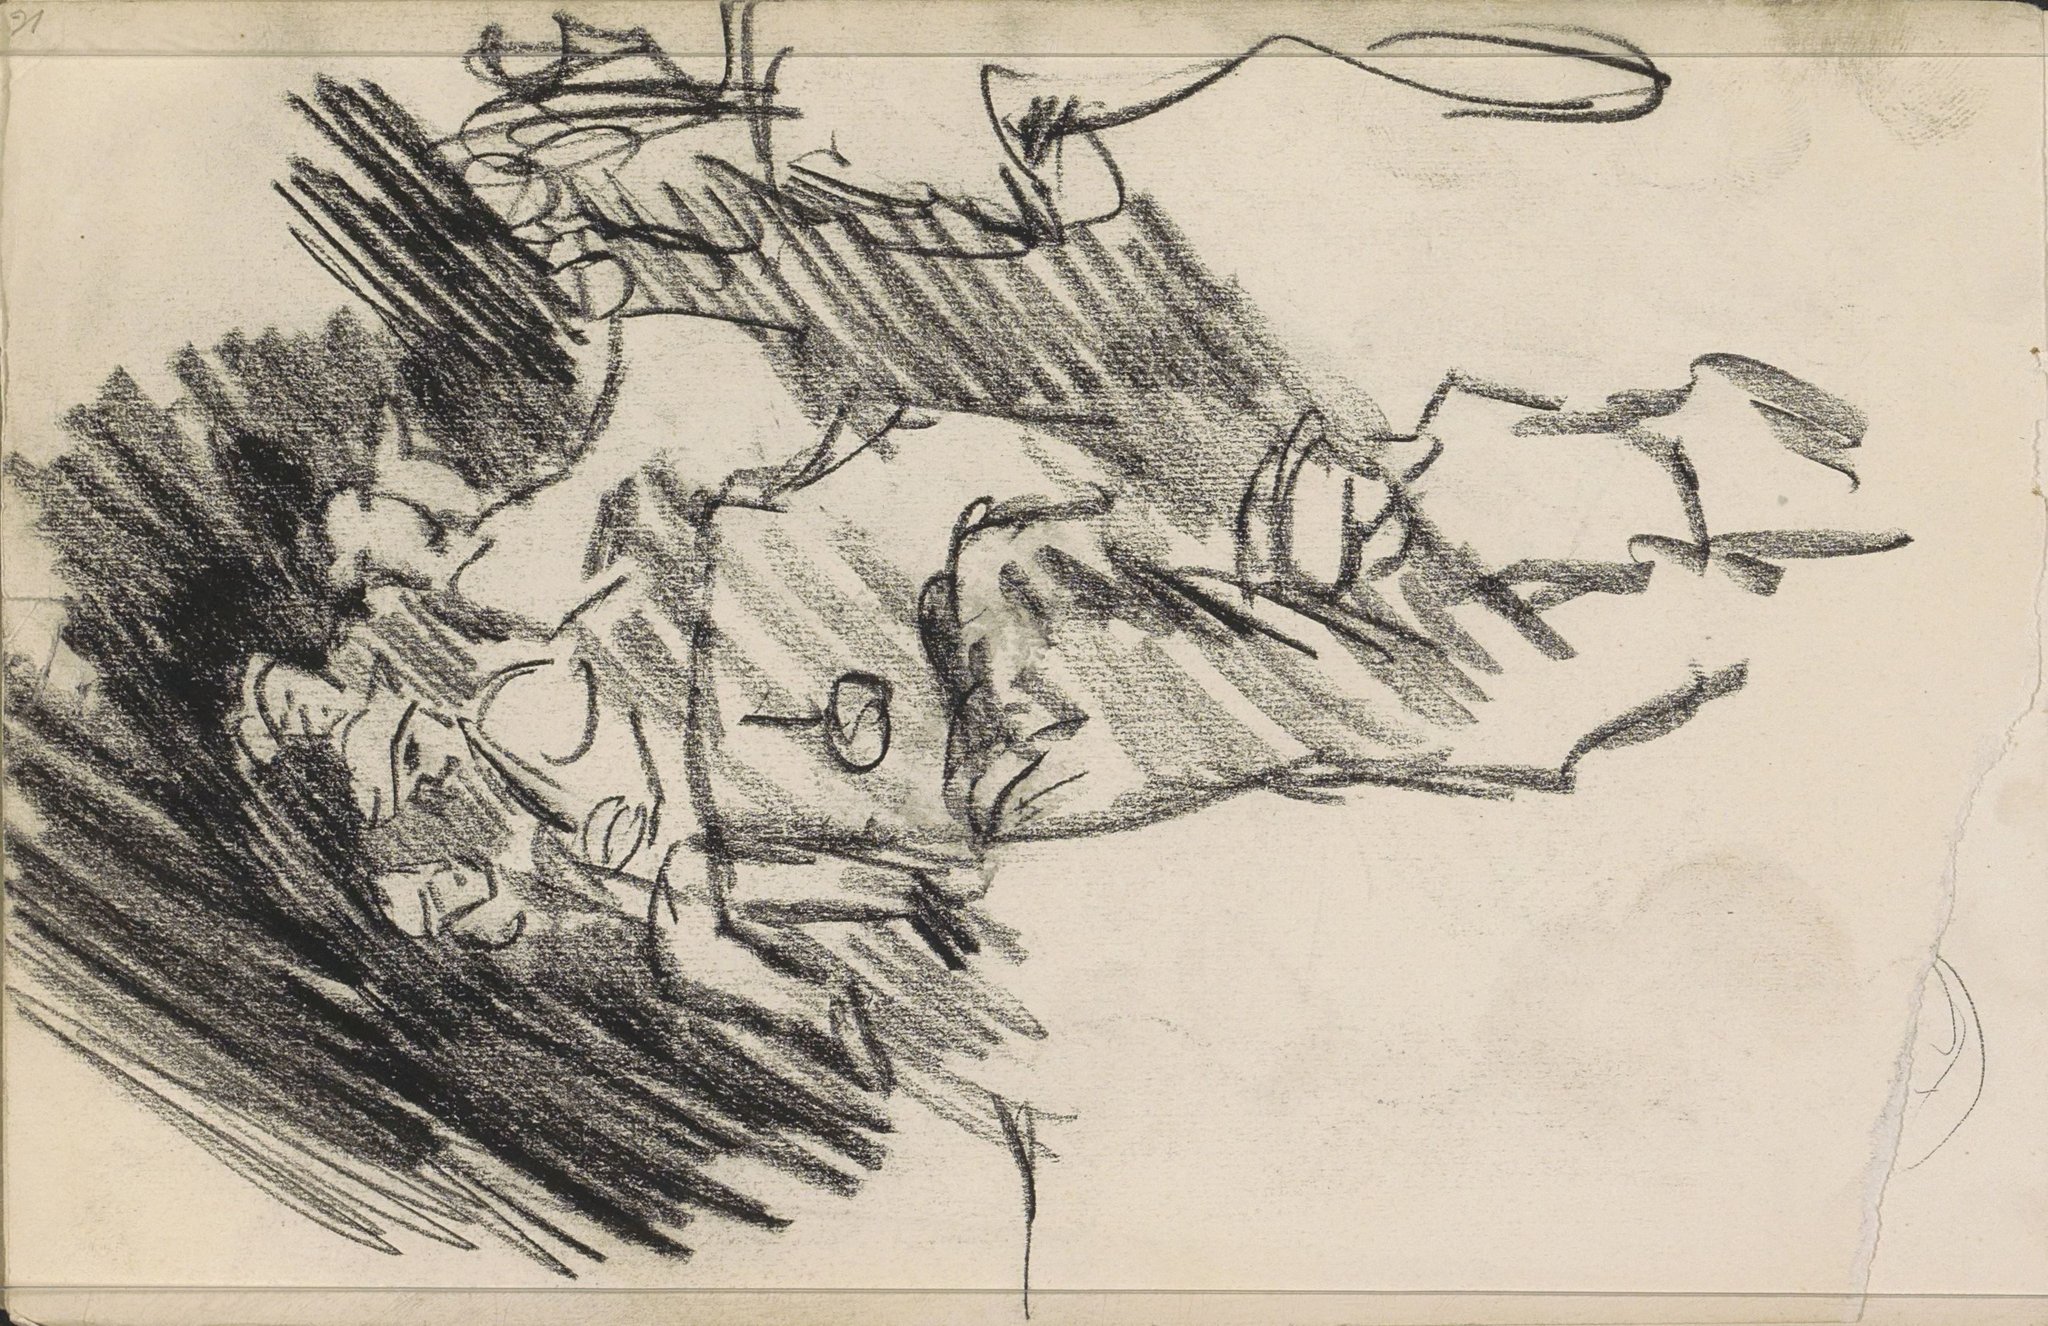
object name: sketchbook leaf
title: Figuren op een olifant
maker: isaac israels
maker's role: draughtsman, painter, print maker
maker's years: 1865-1934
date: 1875-1934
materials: chalk, paper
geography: paris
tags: elephants (circus performance), riding on animal other than horse, ass, or mule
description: Bij zijn slurf staat een figuur. Ernaast een tweede olifant. Blad 7 verso uit schetsboek LI met 11 bladen.